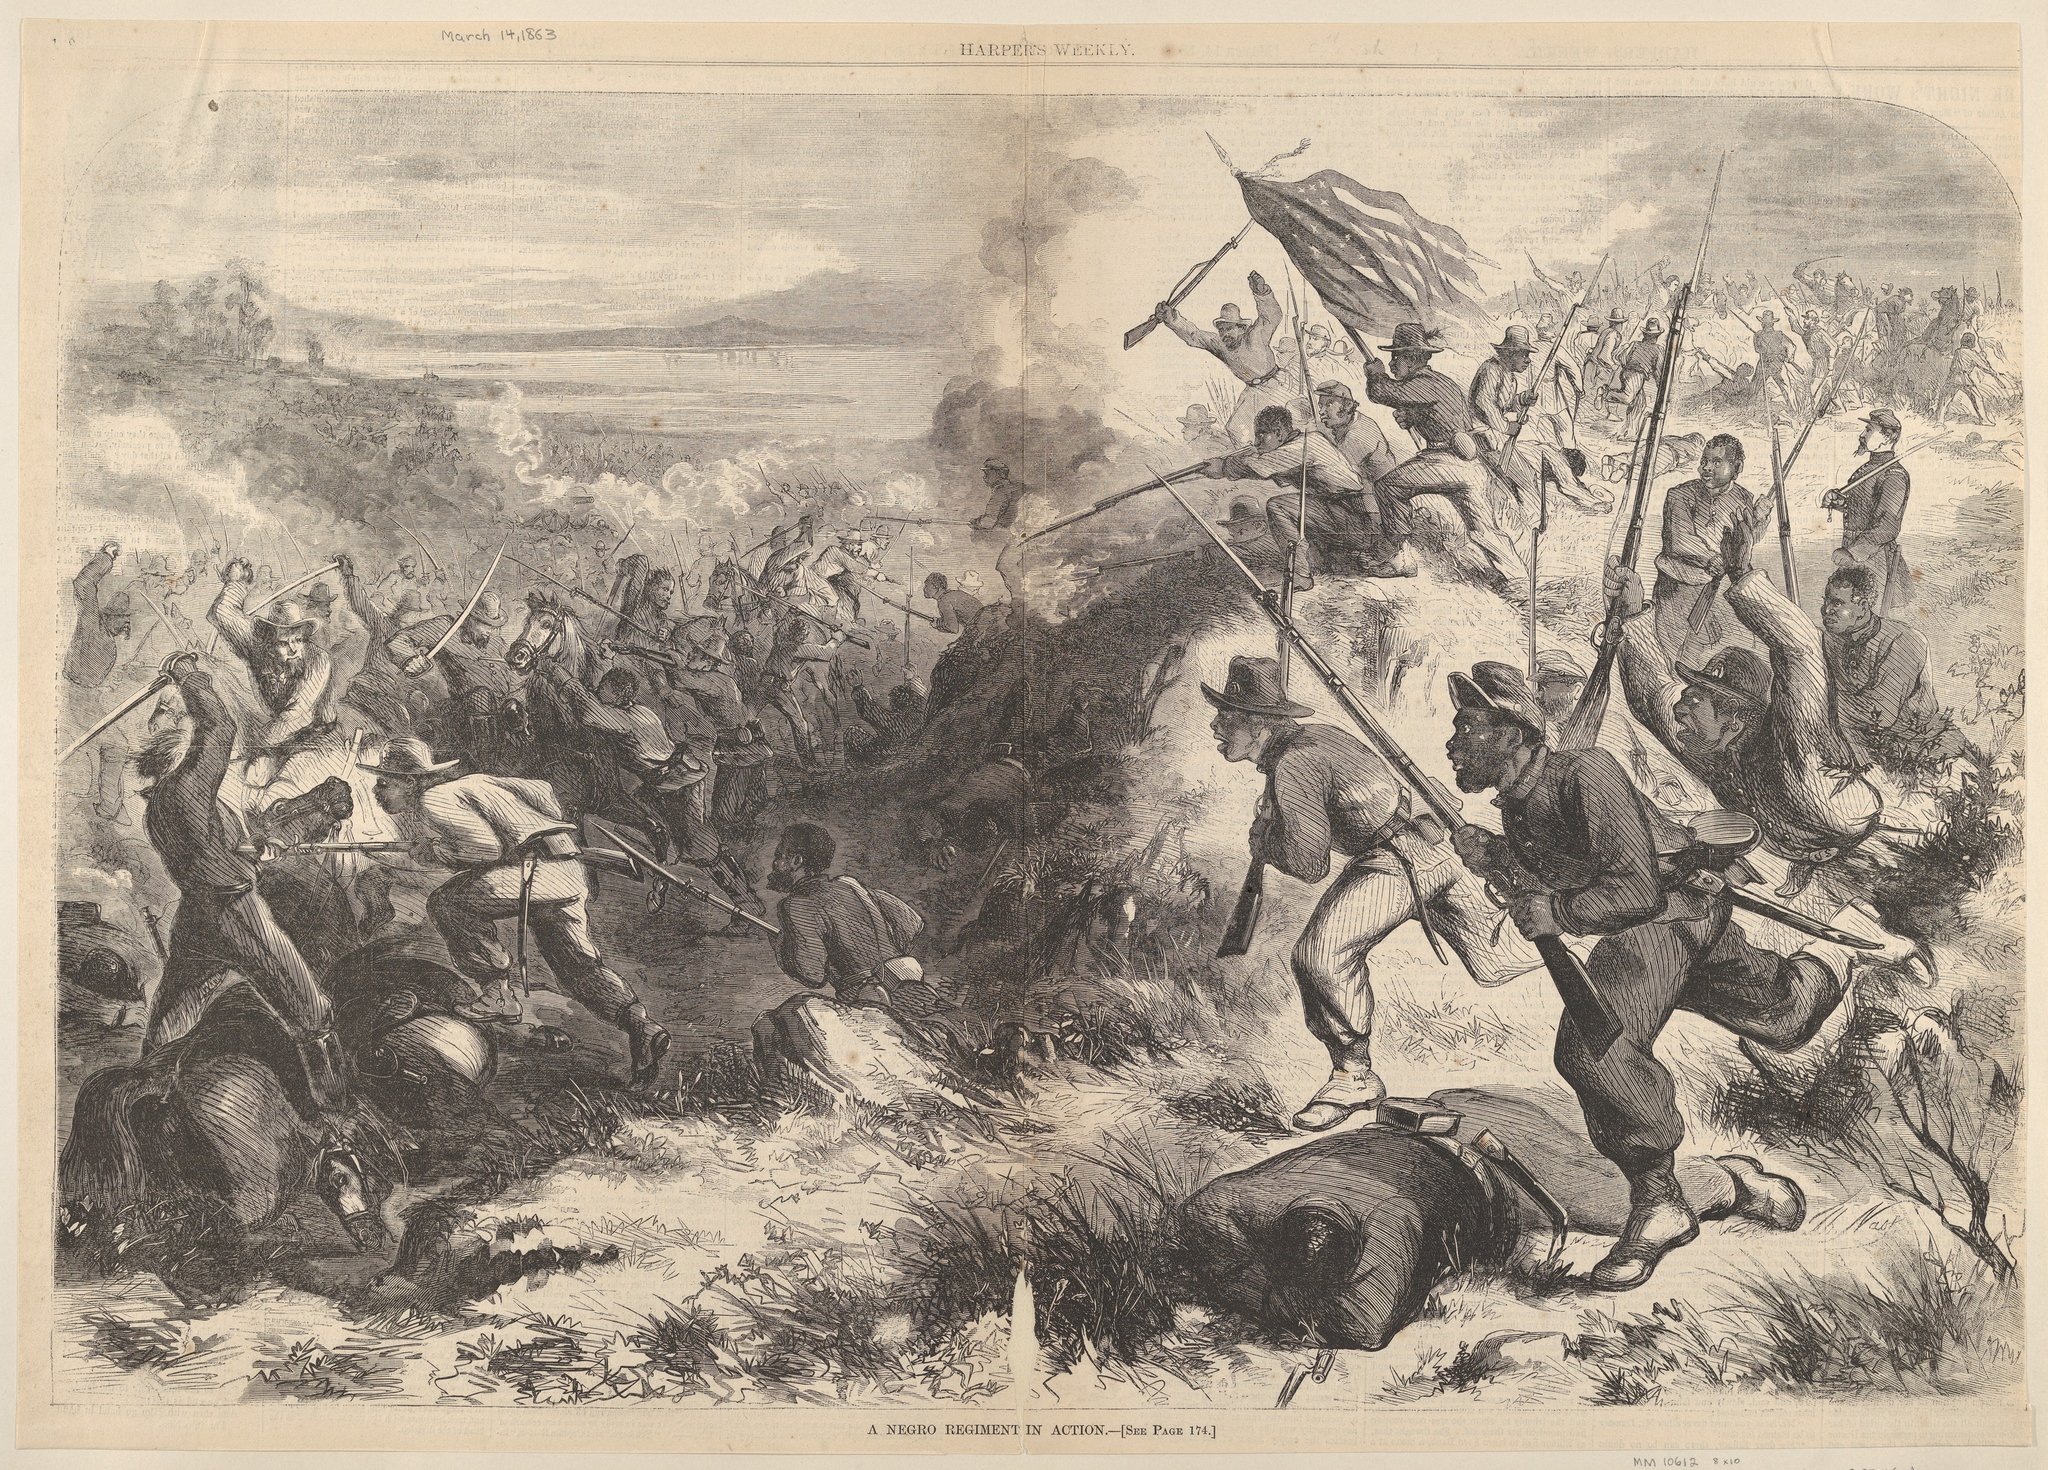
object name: print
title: A "Negro" Regiment in Action (from "Harper's Weekly")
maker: thomas nast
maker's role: artist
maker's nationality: american, born germany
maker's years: 1840-1902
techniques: engraving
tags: battles,soldiers,american civil war